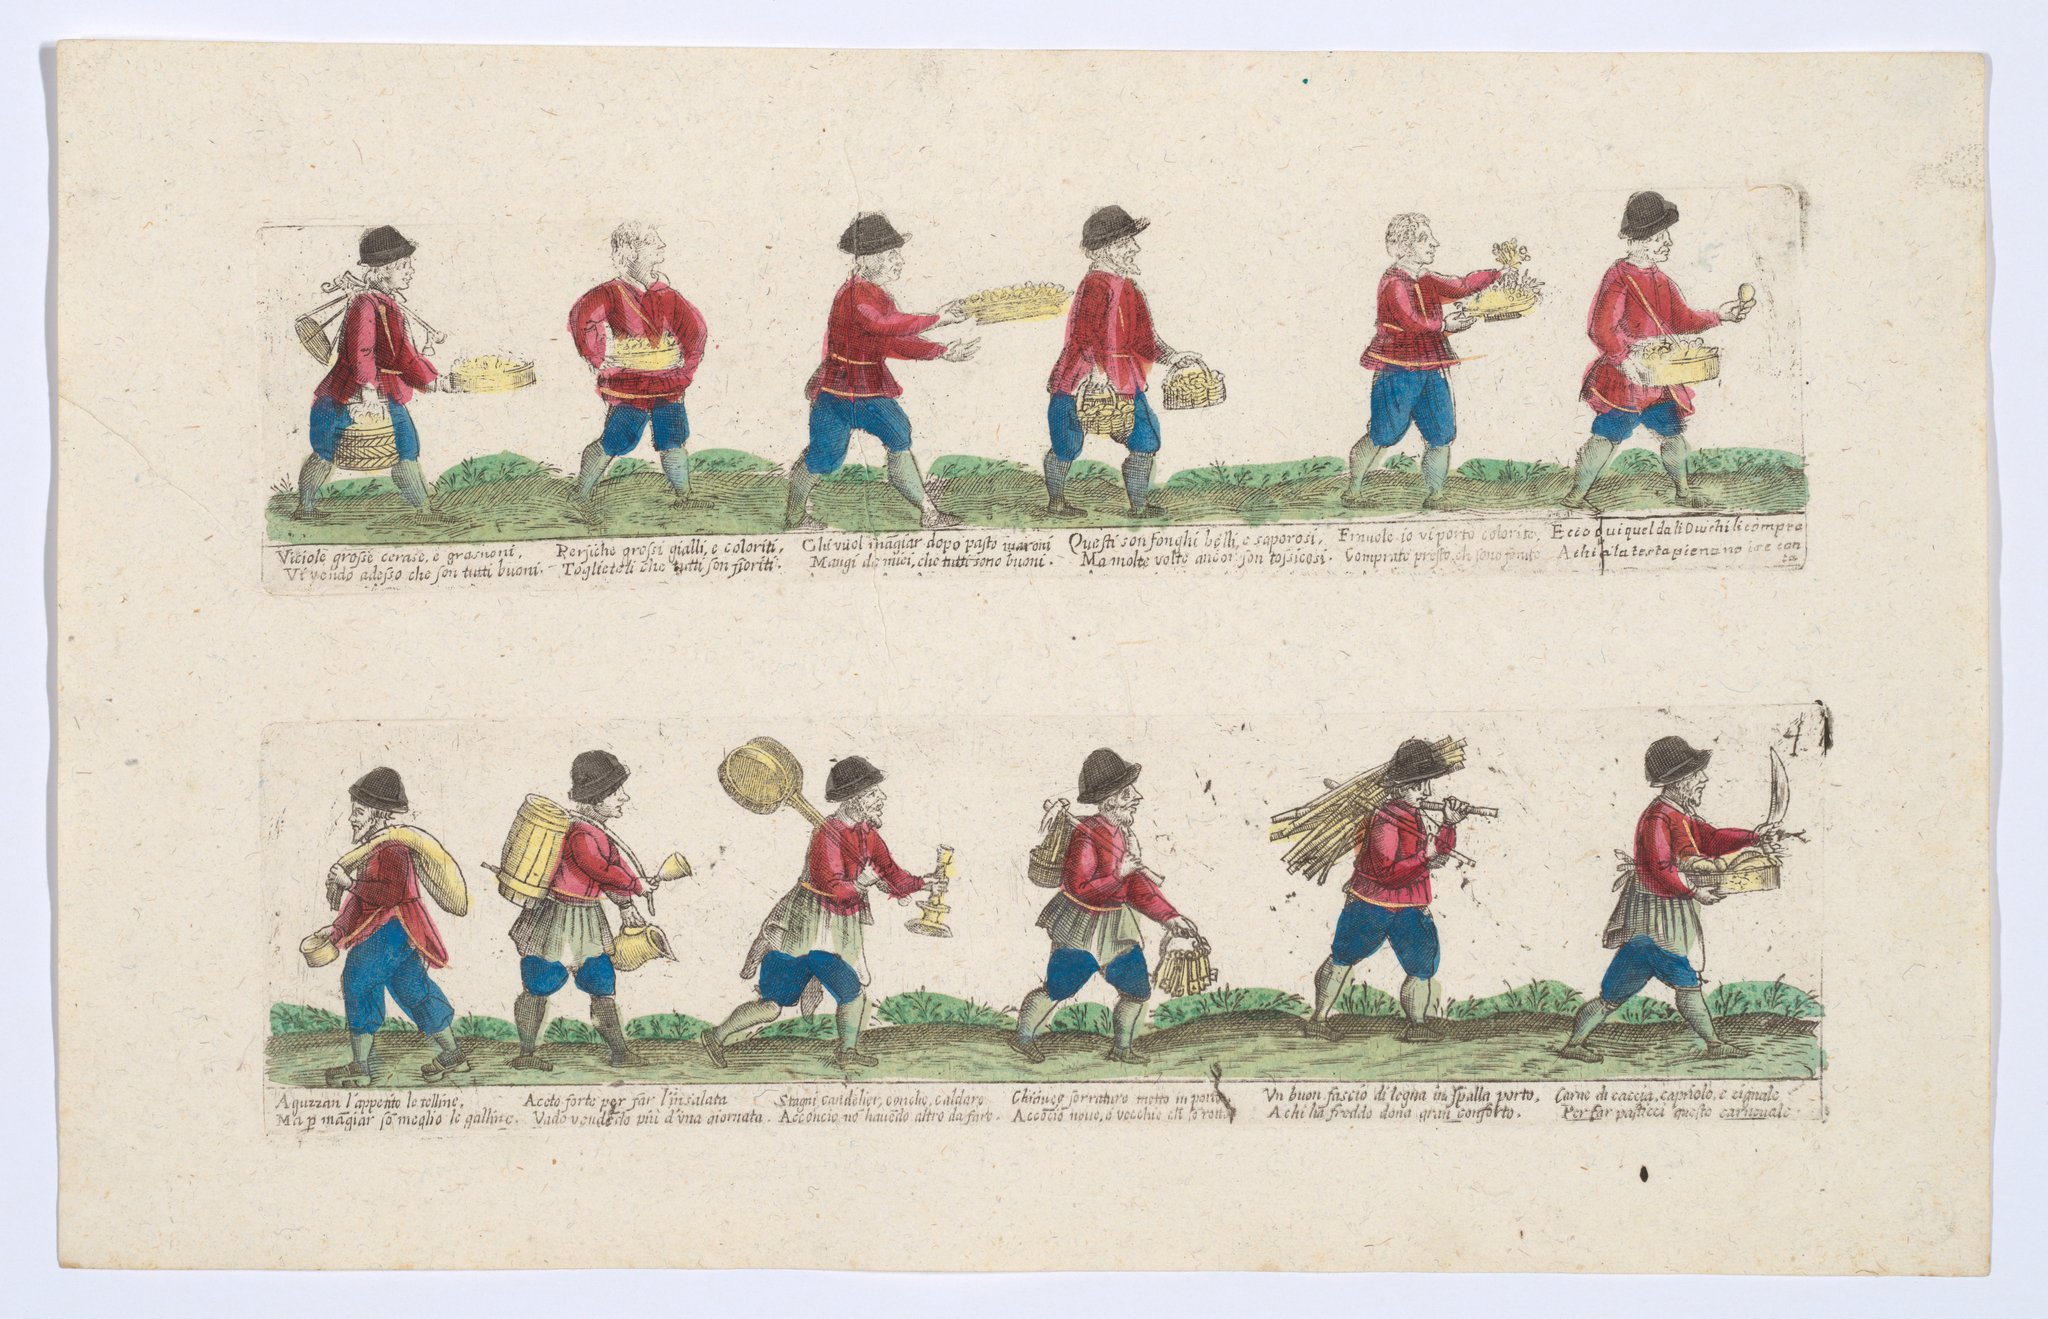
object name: print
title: Plate 4 (second group) depicting the trades of Rome, here including vendors of mushrooms, strong oil, keys, candlesticks etc, from the 'Descrición de las artes que se llaman para los calles de la ciudad de Roma'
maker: remondini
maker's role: publisher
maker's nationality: italian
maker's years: 1650-1860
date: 1770-1800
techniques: engraving, hand coloring